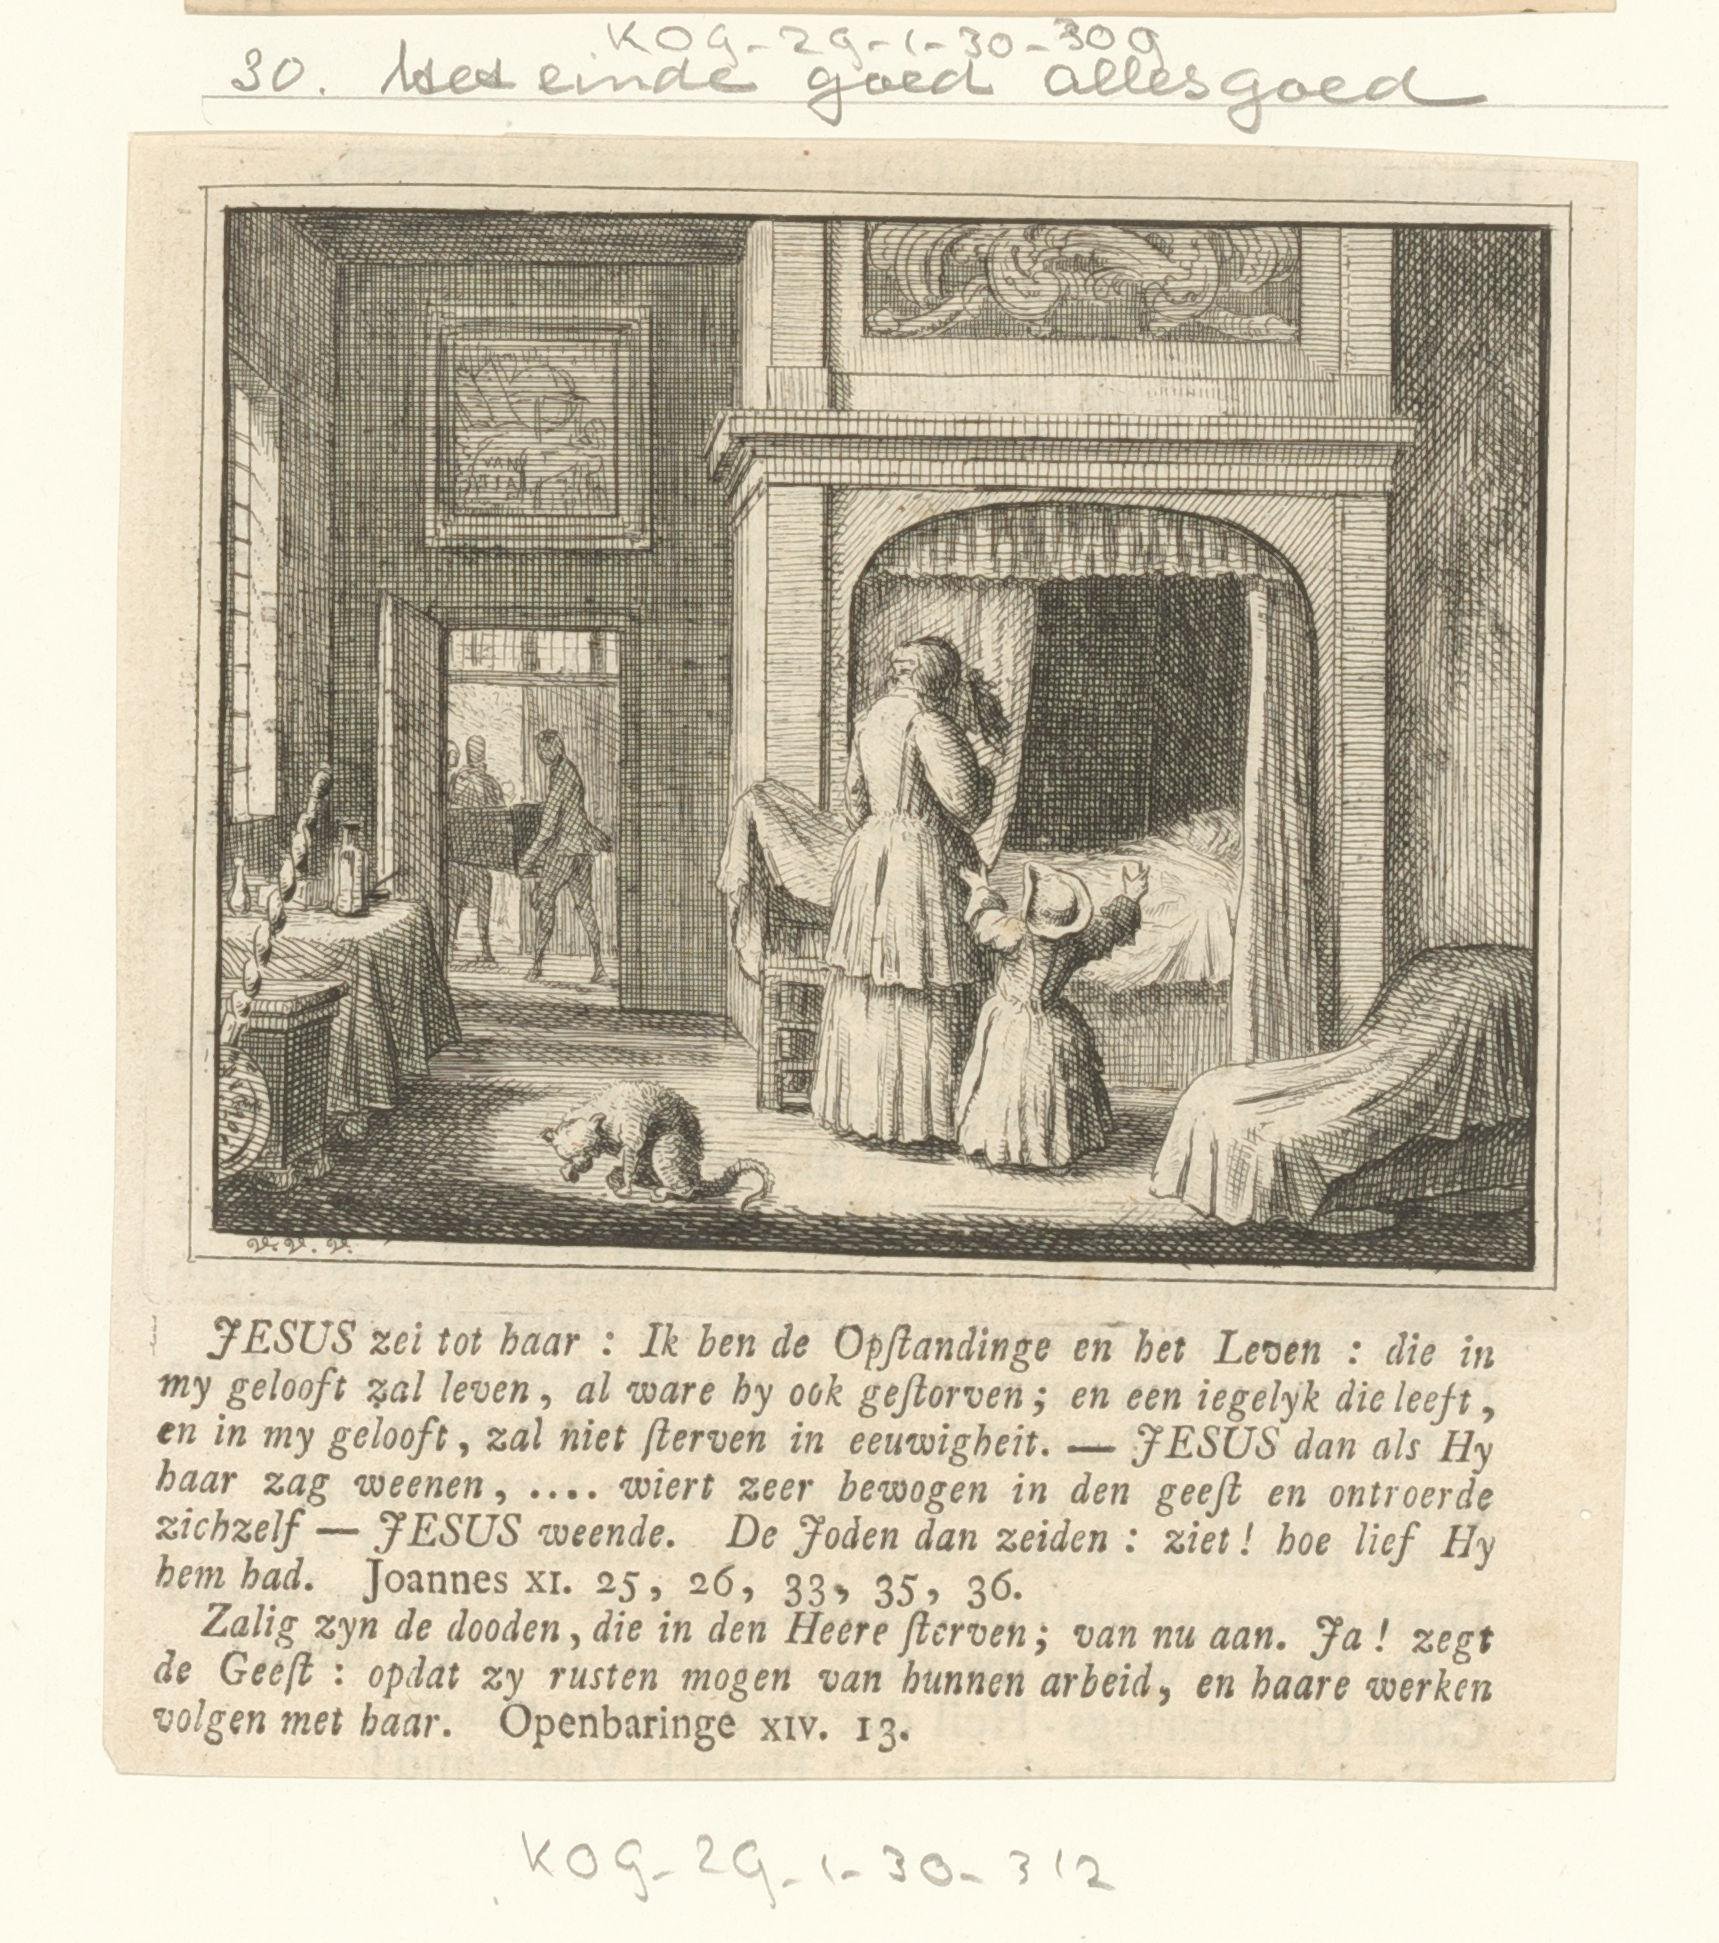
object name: print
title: Moeder en kind bij een ziek persoon in bed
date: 1758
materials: paper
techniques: etching, letterpress printing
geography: haarlem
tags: deathbed, proverbs, sayings, etc., mother and daughter(s) (family group), built-in bedstead (dutch: 'bedstee')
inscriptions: stamp, collector's mark: Lugt 1641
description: Embleem bij het motto: Het Einde goed alles goed. Onderaan een negenregelige tekst in het Nederlands. Onderwerpsrubrieken binnen de Atlas Zeden en Gewoonten: Zeden en Gewoonten in engeren zin. Volksleven. Zinnebeeldige voorstellingen uit het volkleven op serieprenten. Maanden en diversen (allegorieën).